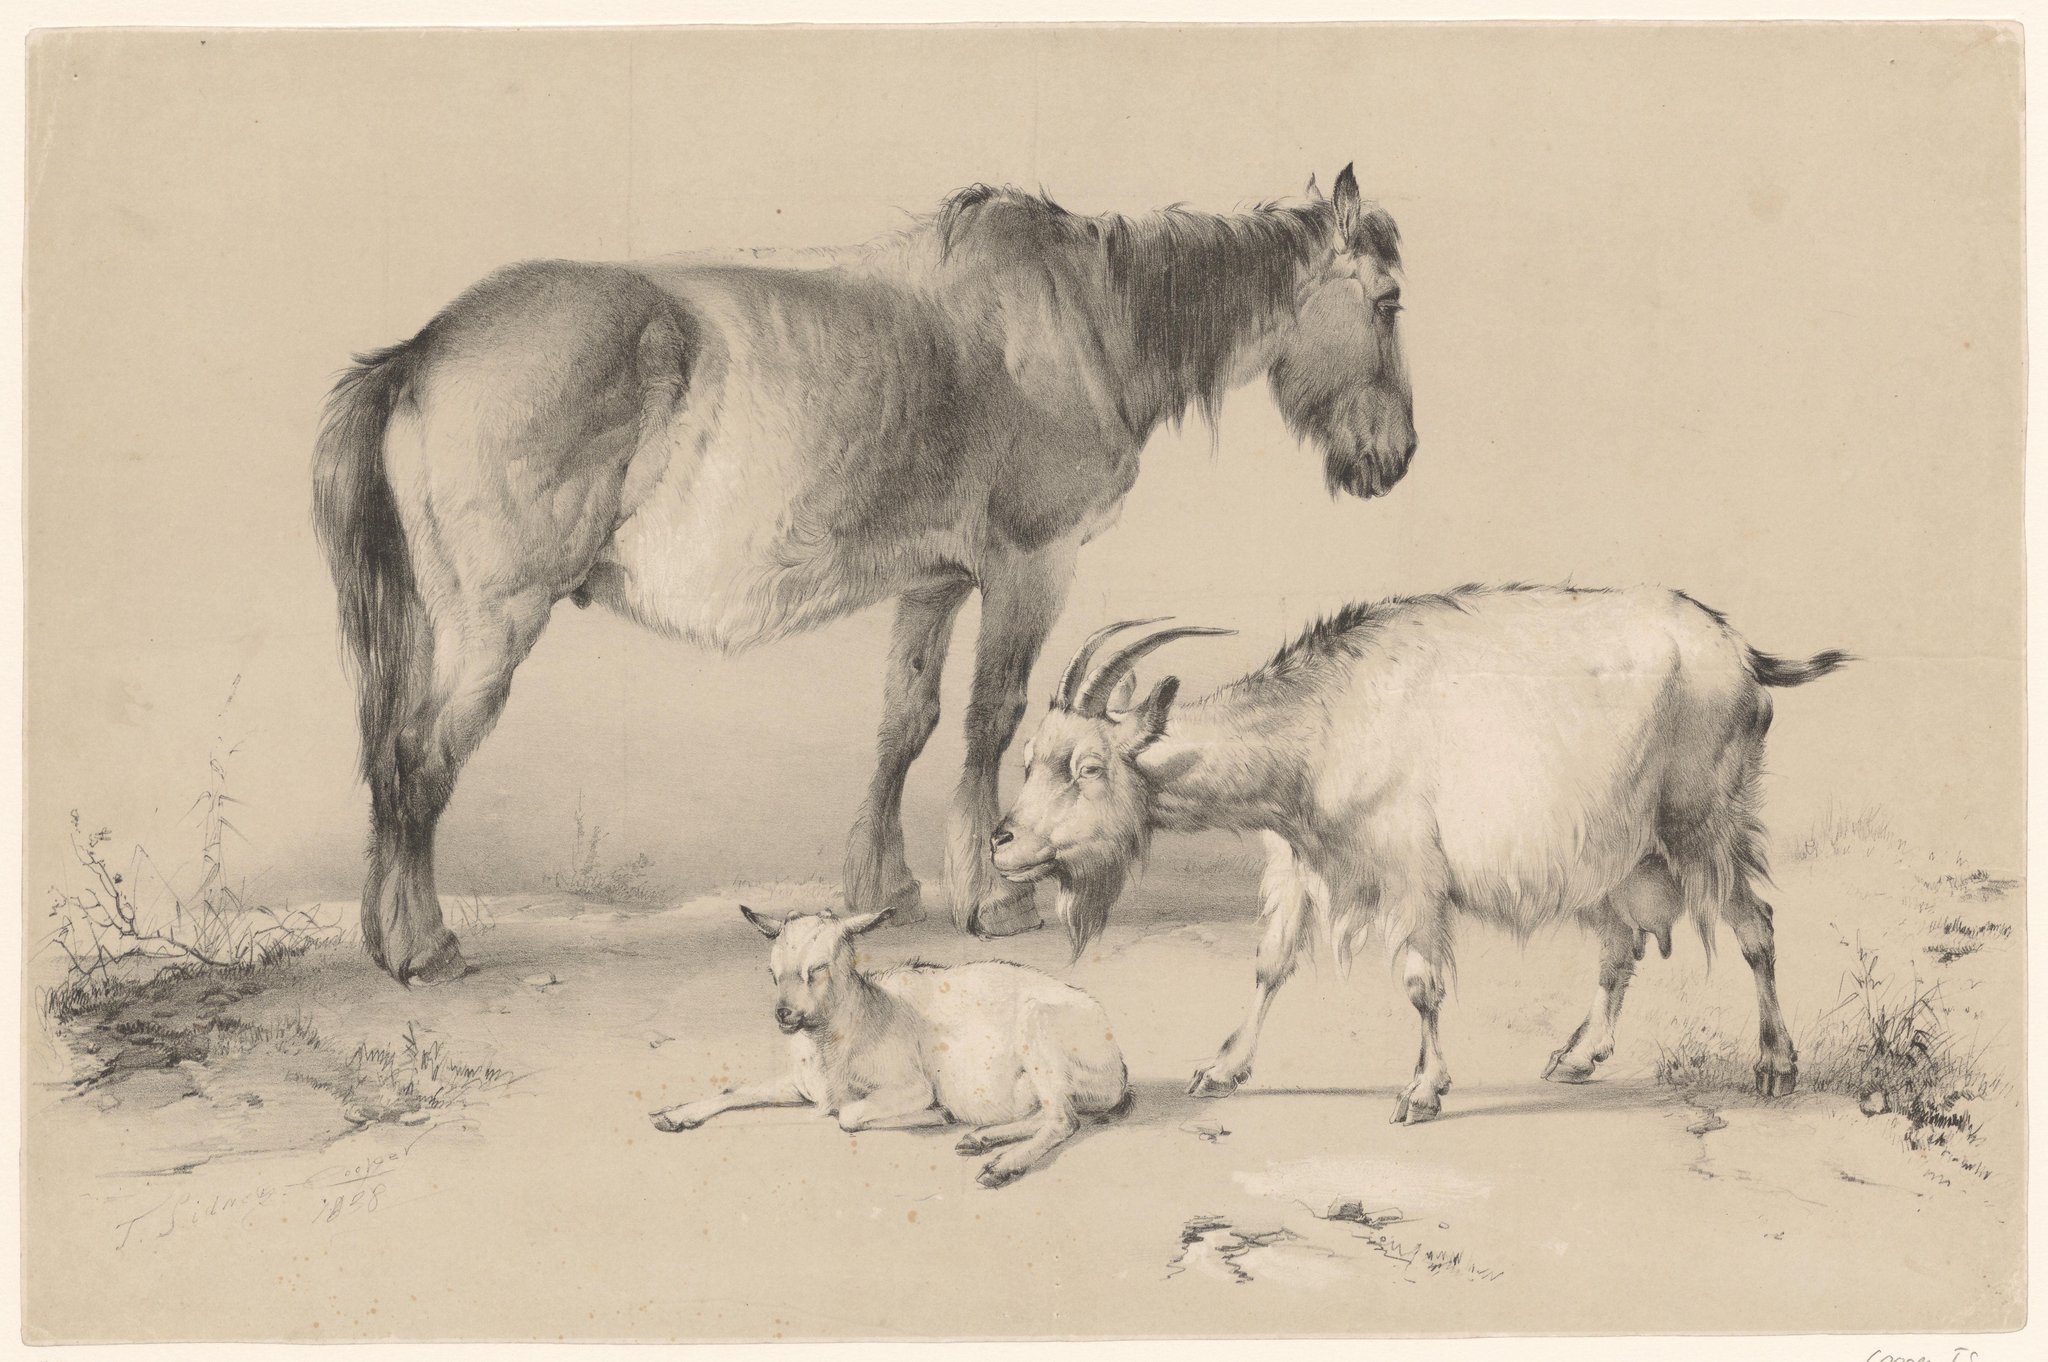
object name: print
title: Dierstudies door Thomas Sidney Cooper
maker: thomas sidney cooper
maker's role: print maker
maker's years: 1803-1902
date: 1838-1839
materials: paper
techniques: tone lithography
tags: horse, goat, kid (goat)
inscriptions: collector's mark: Lugt 2228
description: Prent maakt waarschijnlijk deel uit van de serie 'Groups of cattle, drawn from nature by T.S. Cooper 1839' gedrukt bij Hullmandel en in 1839 uitgegeven door Ackermann. De serie bestaat uit 26 prenten.